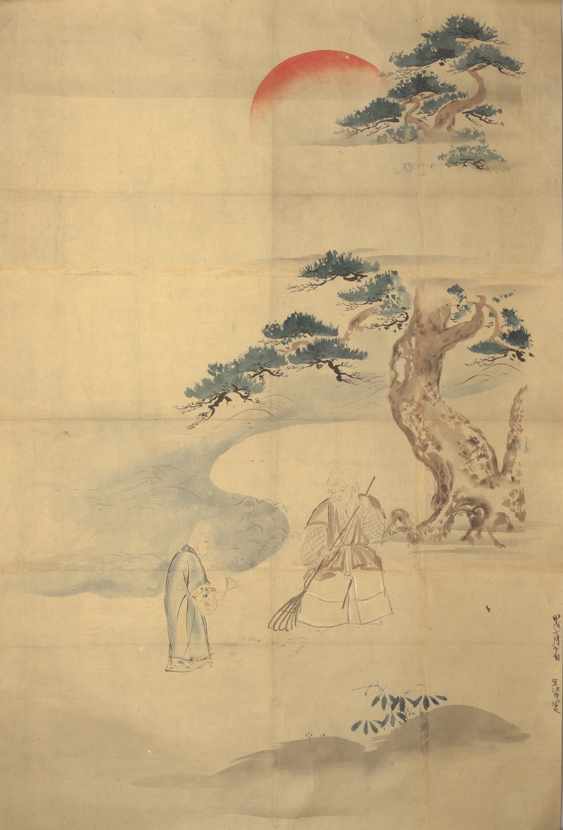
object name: drawing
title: Japanese Drawing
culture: japanese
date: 1801-1833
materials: paper